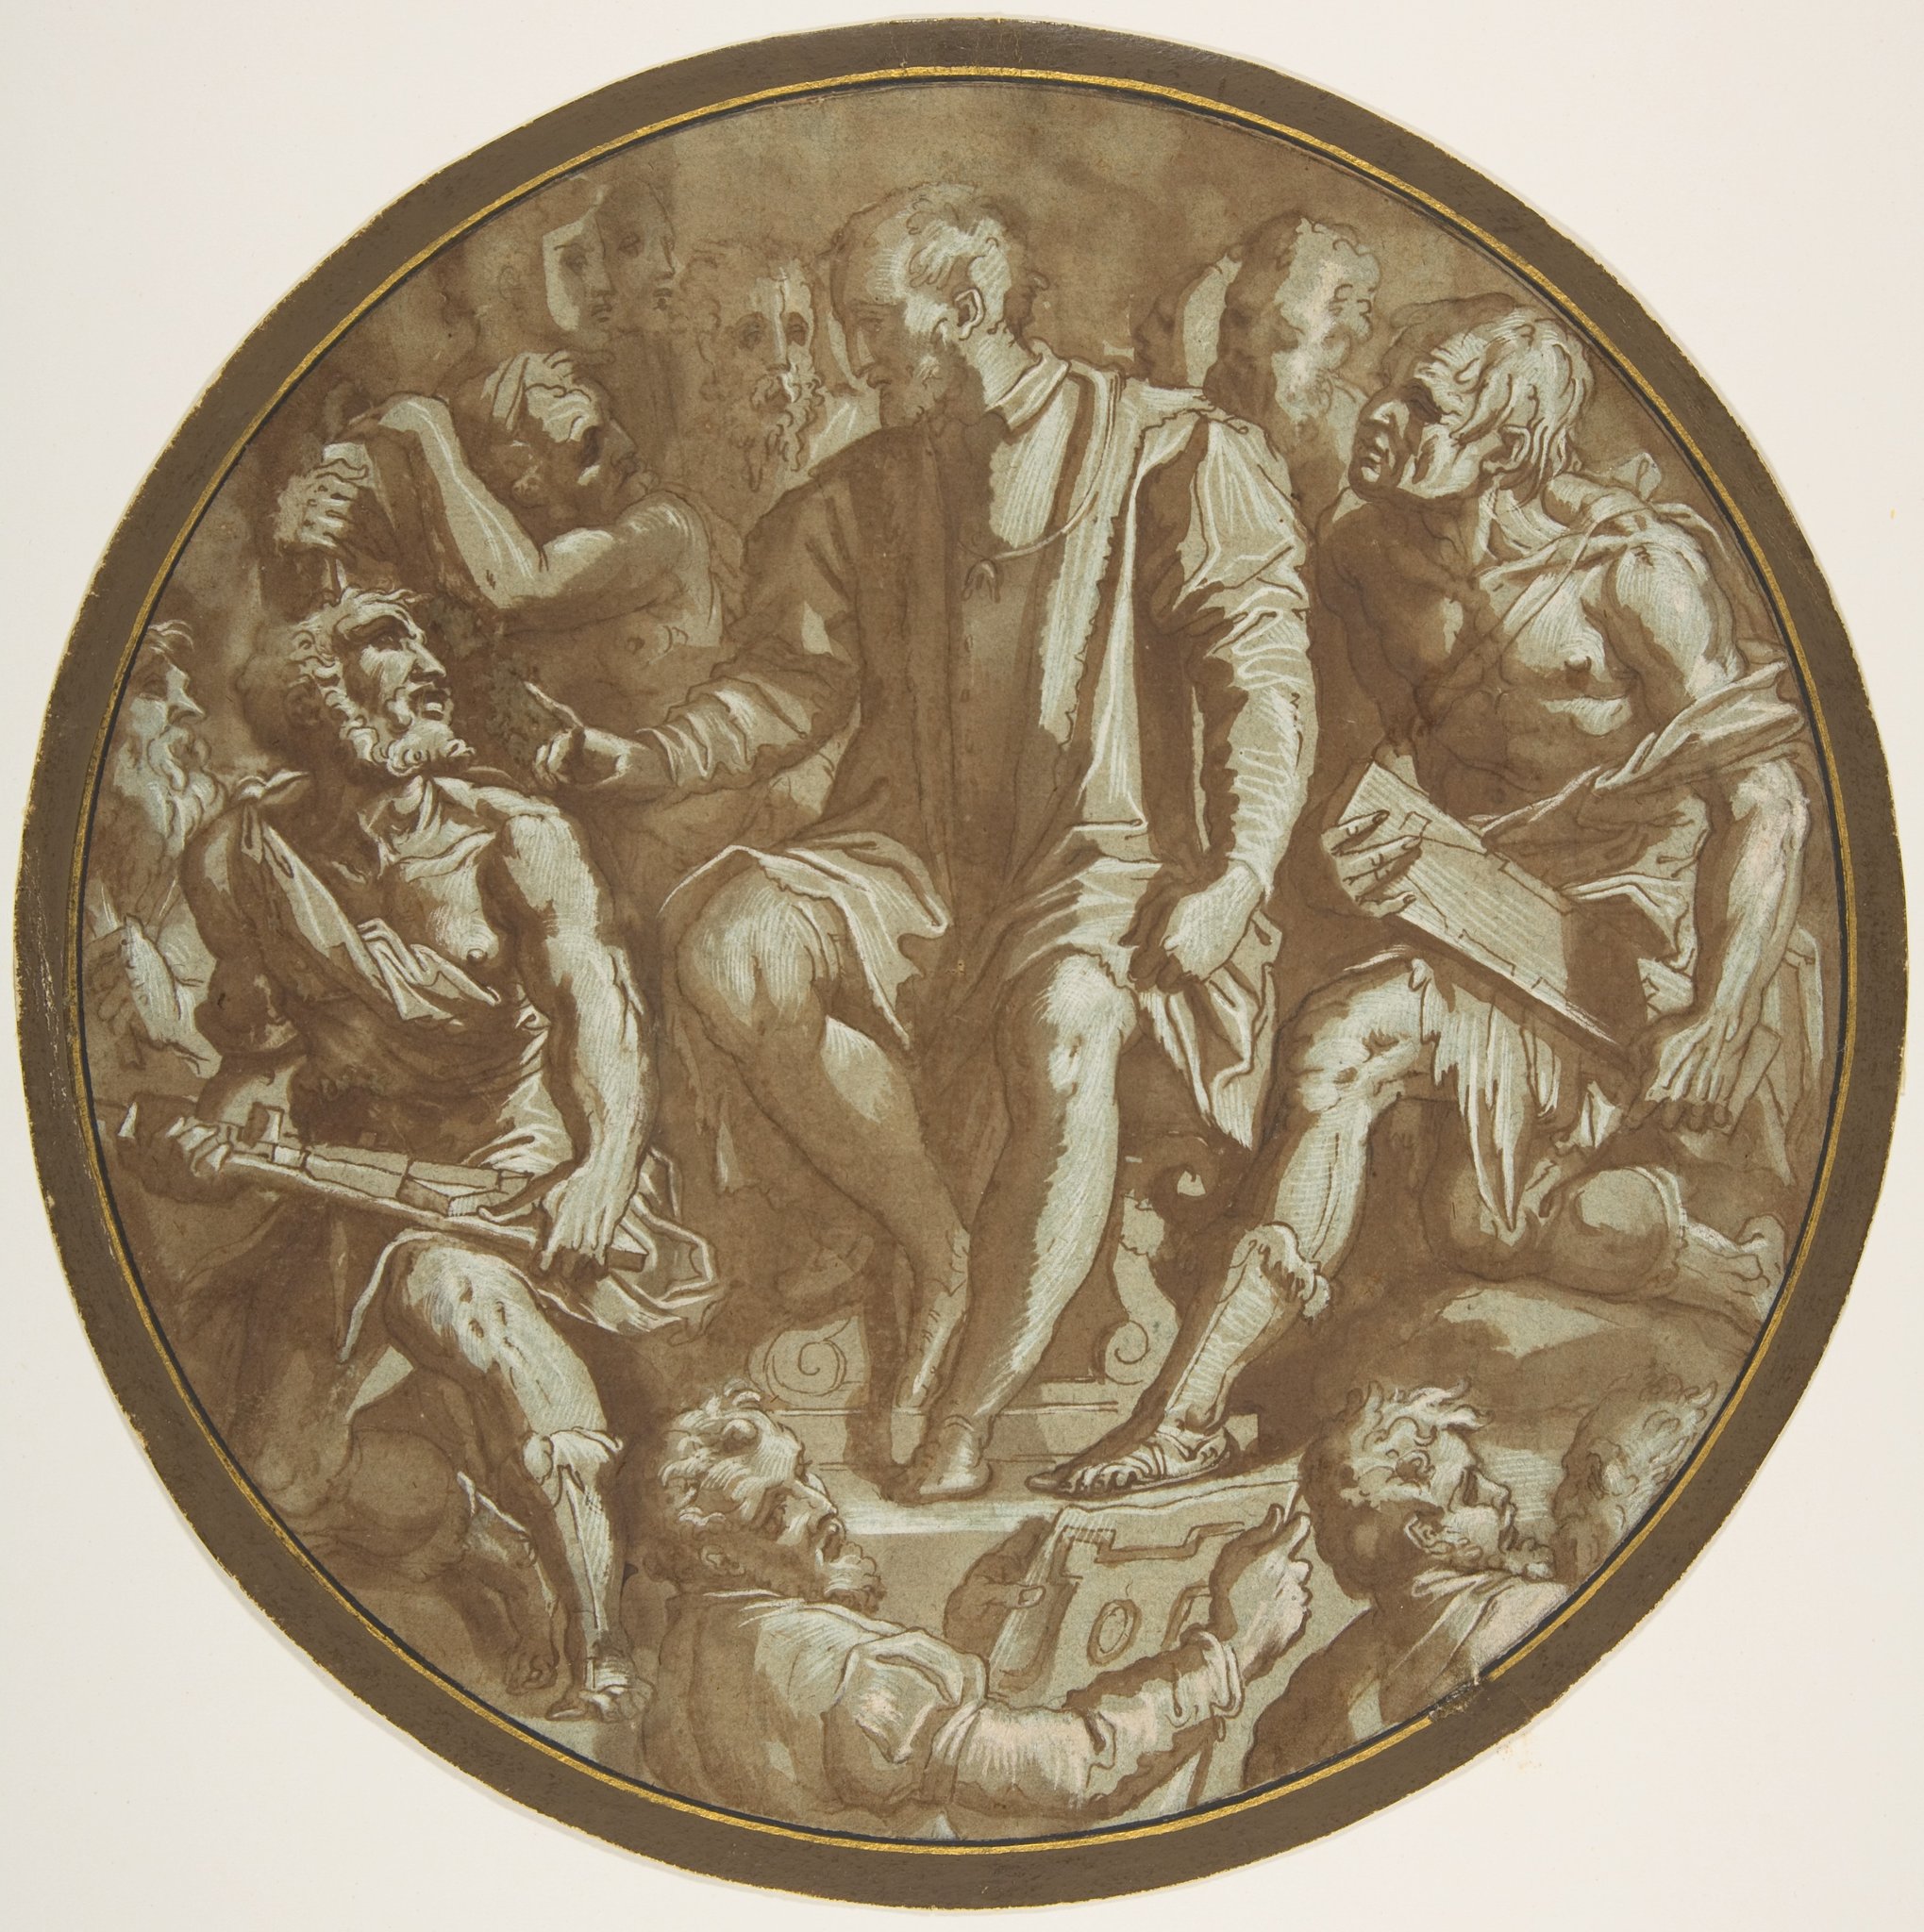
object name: drawing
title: Grand Duke Cosimo I of Tuscany Surrounded by his Artists.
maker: giorgio vasari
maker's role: artist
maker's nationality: italian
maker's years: 1511-1574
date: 1556-1562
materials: chalk, gouache, graphite, ink, paper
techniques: brush, highlighting, pen, wash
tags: musical instruments,men